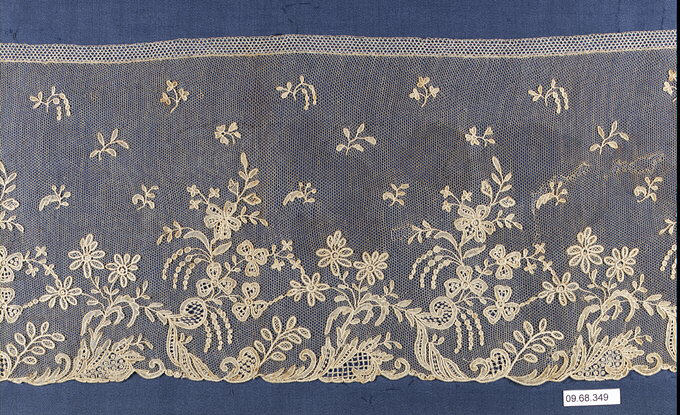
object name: fragment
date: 1801-1900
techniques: lace